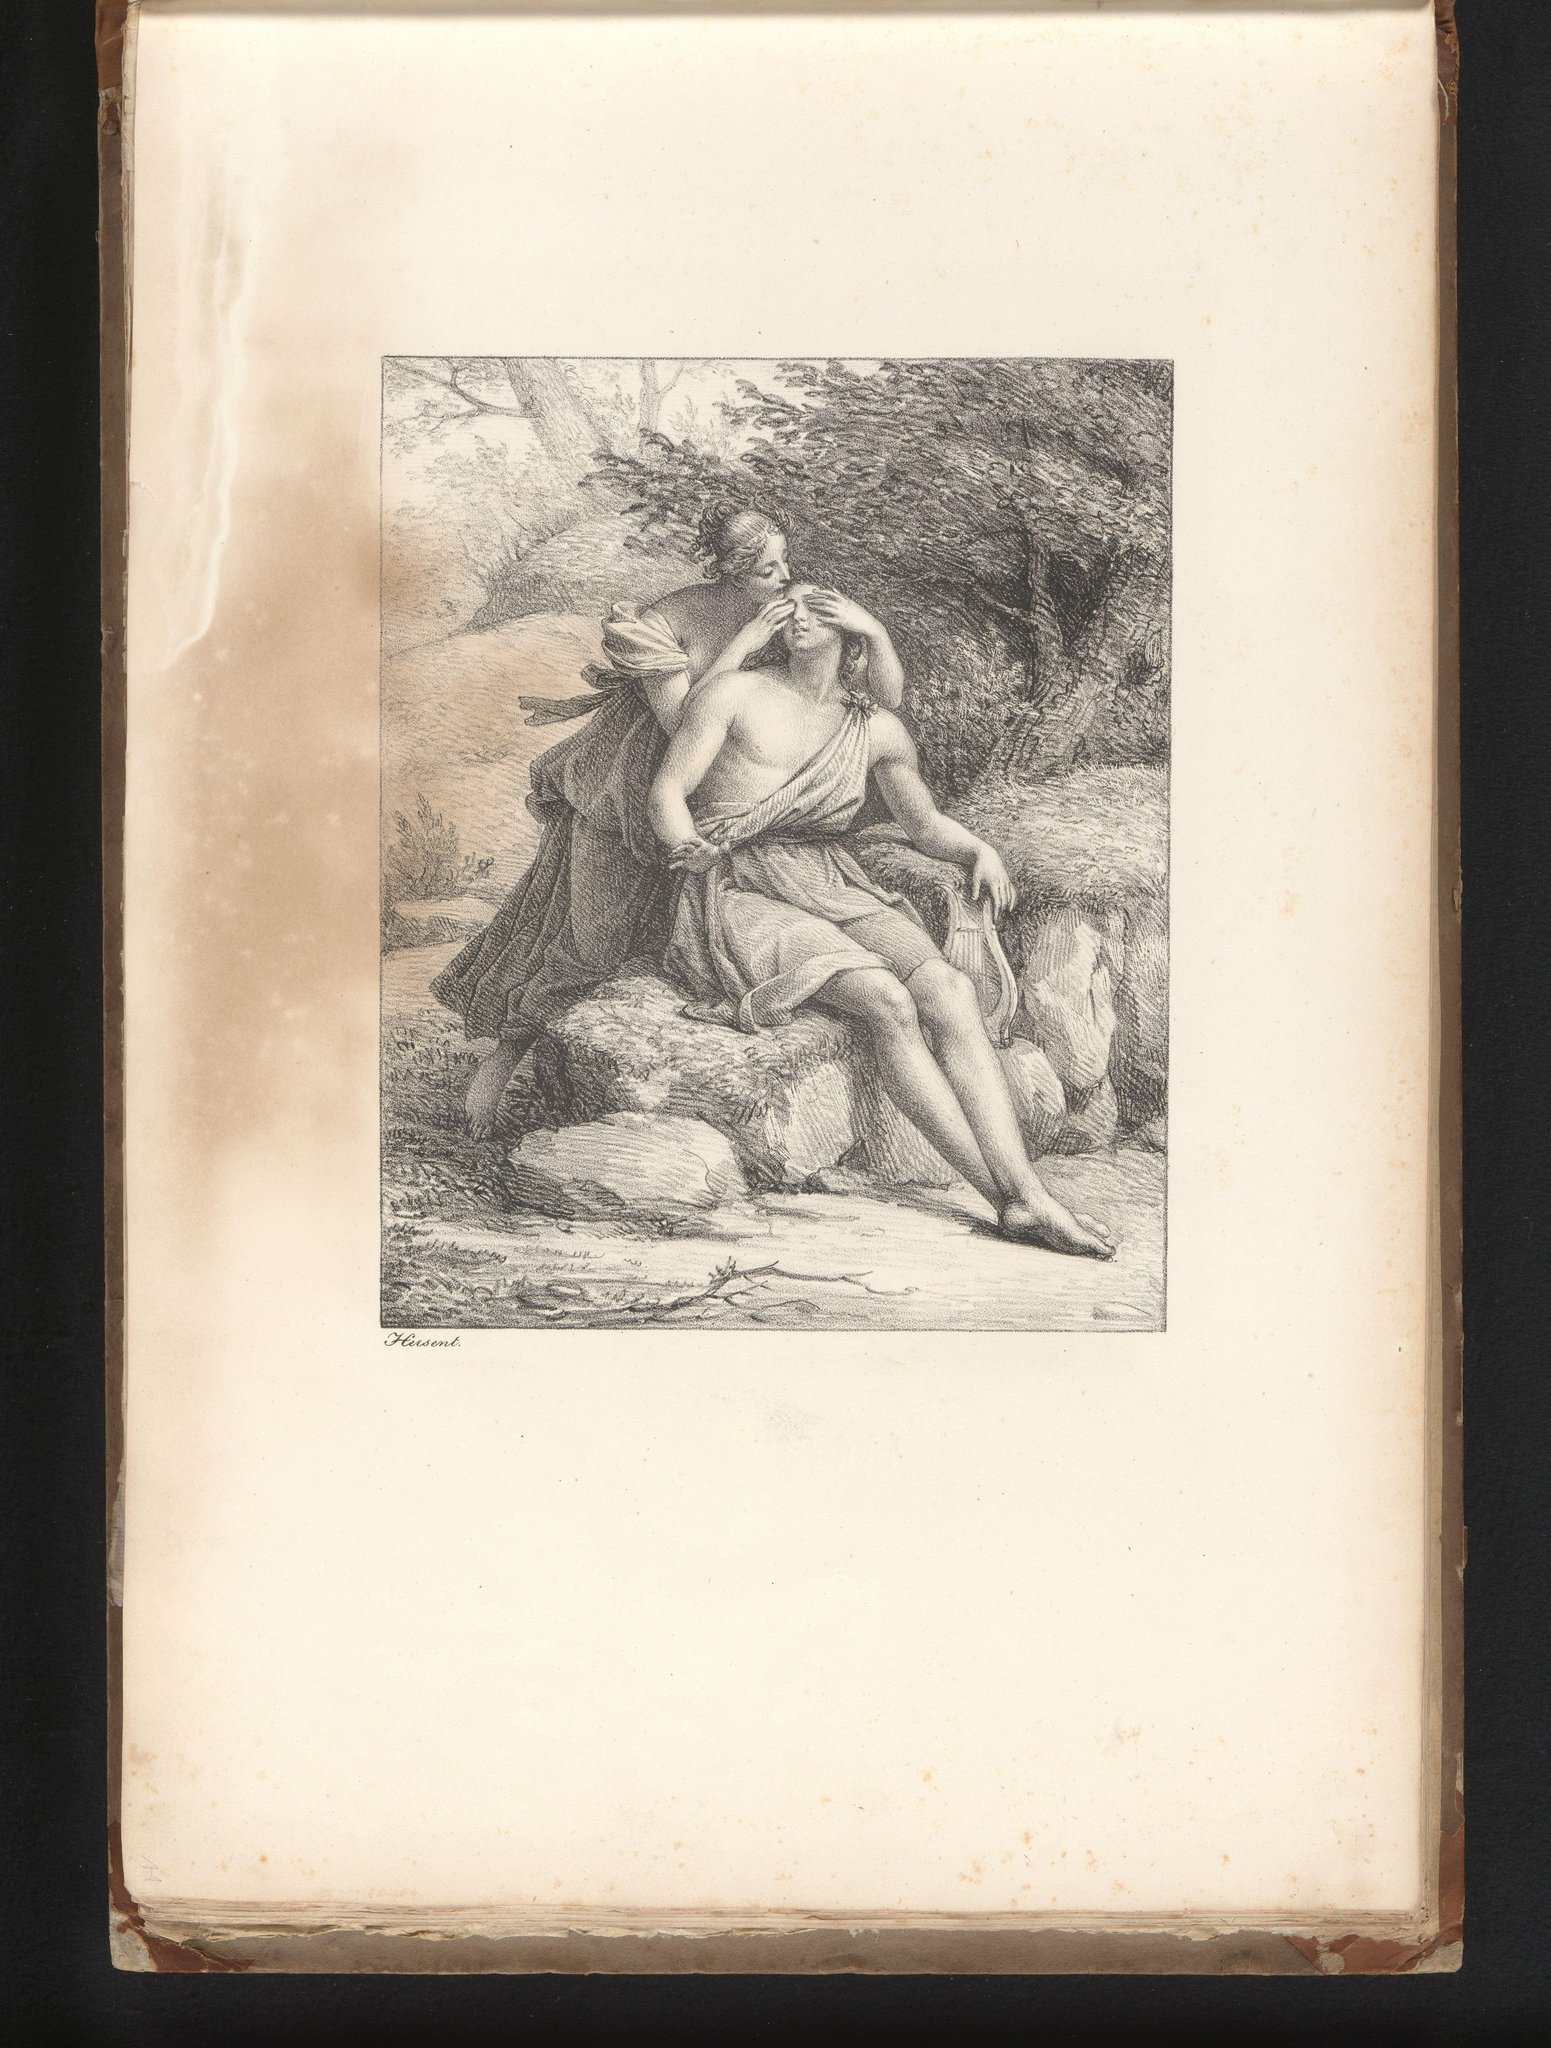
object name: album leaf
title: Serie lithografieën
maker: louis hersent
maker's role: painter, print maker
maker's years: 1777-1860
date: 1818-1819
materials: paper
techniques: lithograph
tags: orpheus and eurydice